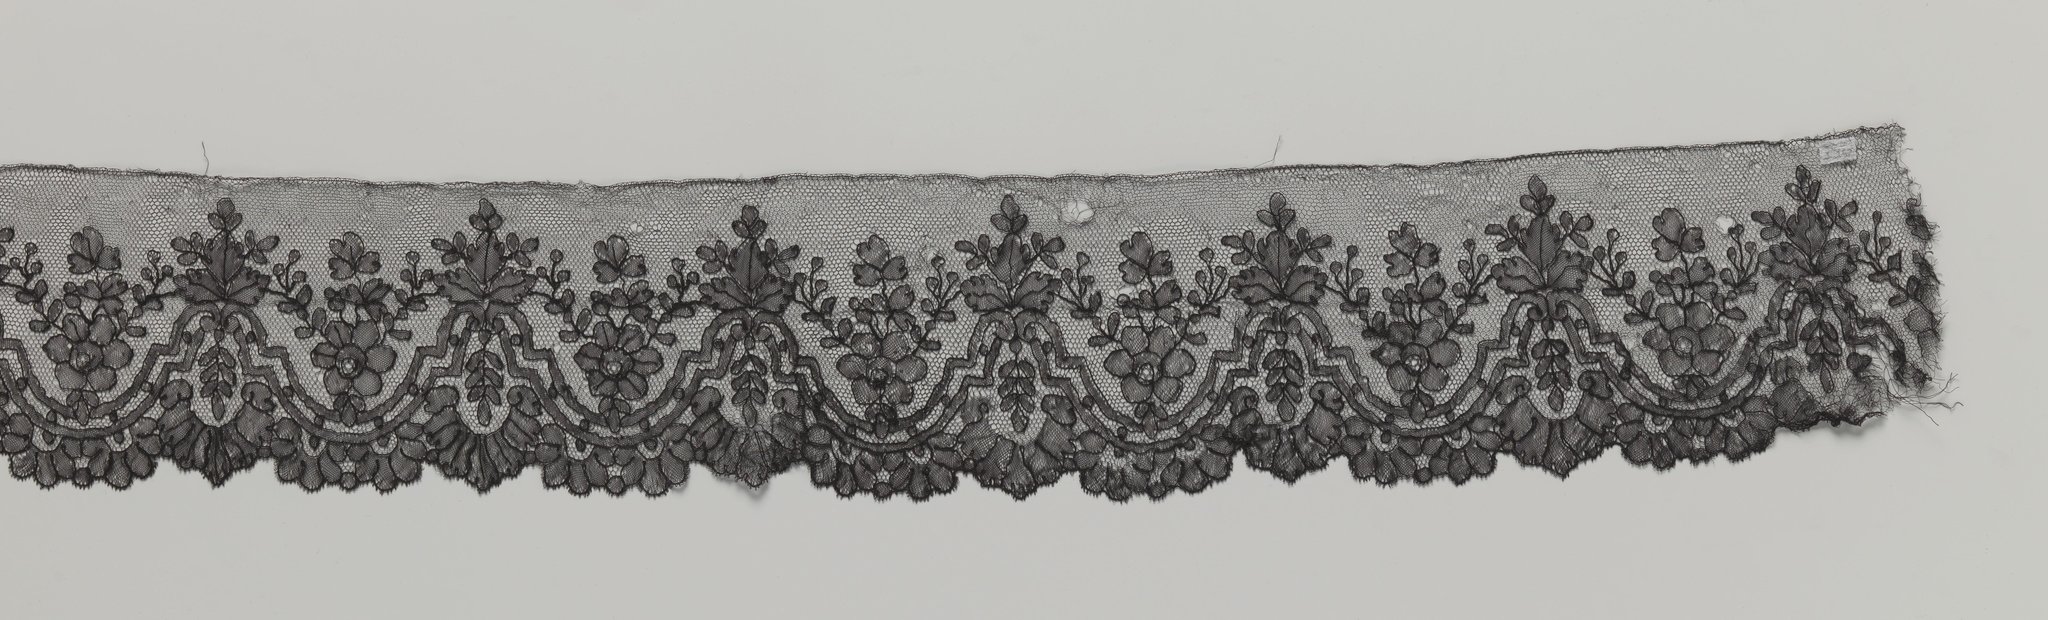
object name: strip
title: Strook zwarte kloskant met roos in u-vormige dubbele sierlijst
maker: Anonymous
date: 1850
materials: silk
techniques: lace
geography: bayeux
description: Strook zwarte kloskant: Chantilly-kant. Het zich herhalende en symmetrische patroon bestaat uit een aaneenschakeling van u-vormige dubbele sierlijsten. Boven de sierlijst hangt een bloemslinger met daaraan bladeren, bloemknoppen en grote hangende rozen, steeds één roos in elk u-vormig veld. Onder de sierlijsten hangen twee halve rozetten afgewisseld door een halve krans van blaadjes. De rozetten en halve kransen vormen de schulpenrand. De motieven zijn gemaakt in netslag en worden geaccentueerd door contourdraden. De motieven zijn met elkaar verbonden door een traliegrond, een tulegrond. In het hart van de roos is een siergrondje toegepast, een rozengrond. De schulpenrand is afgewerkt met picots. De bovenzijde van de strook is recht afgewerkt.